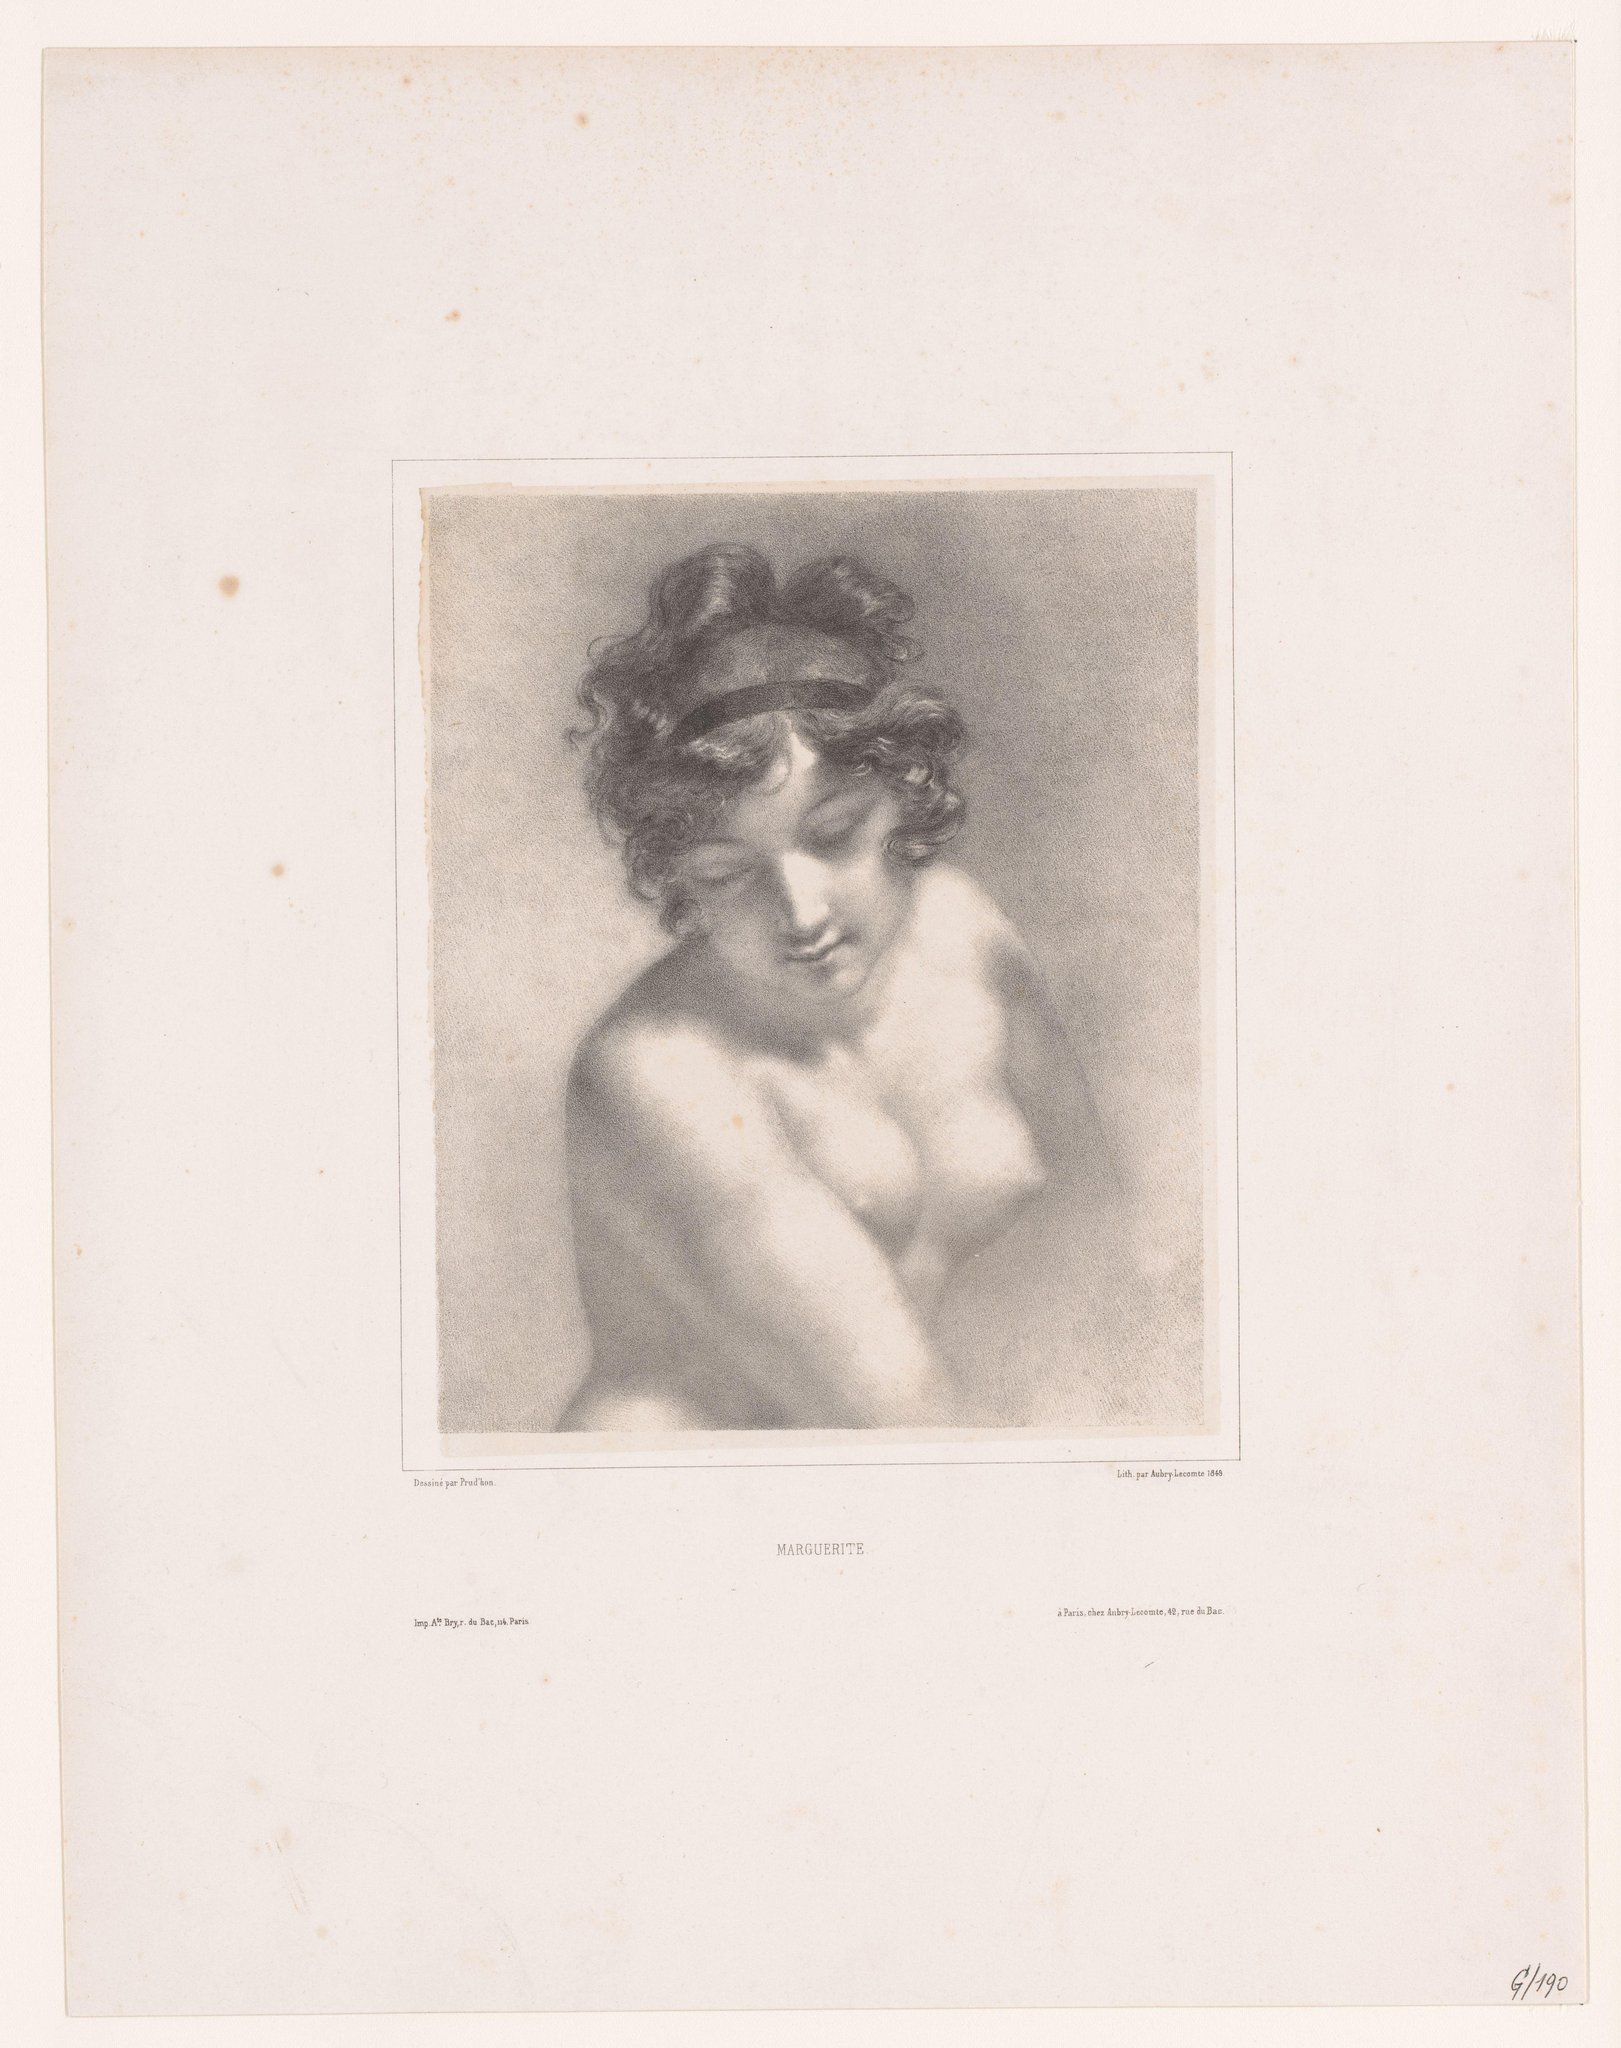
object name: print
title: Omlaag kijkende naakte vrouw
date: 1849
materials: paper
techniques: lithograph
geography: paris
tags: nymphs (in general); 'ninfe in commune' (ripa), looking downwards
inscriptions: collector's mark: Lugt 2228